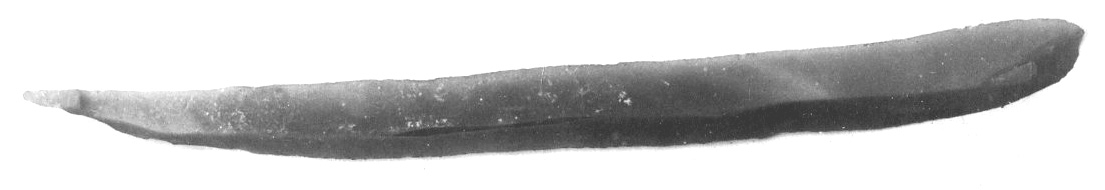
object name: knife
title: Blade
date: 2030-1640 BCE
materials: stone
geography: egypt